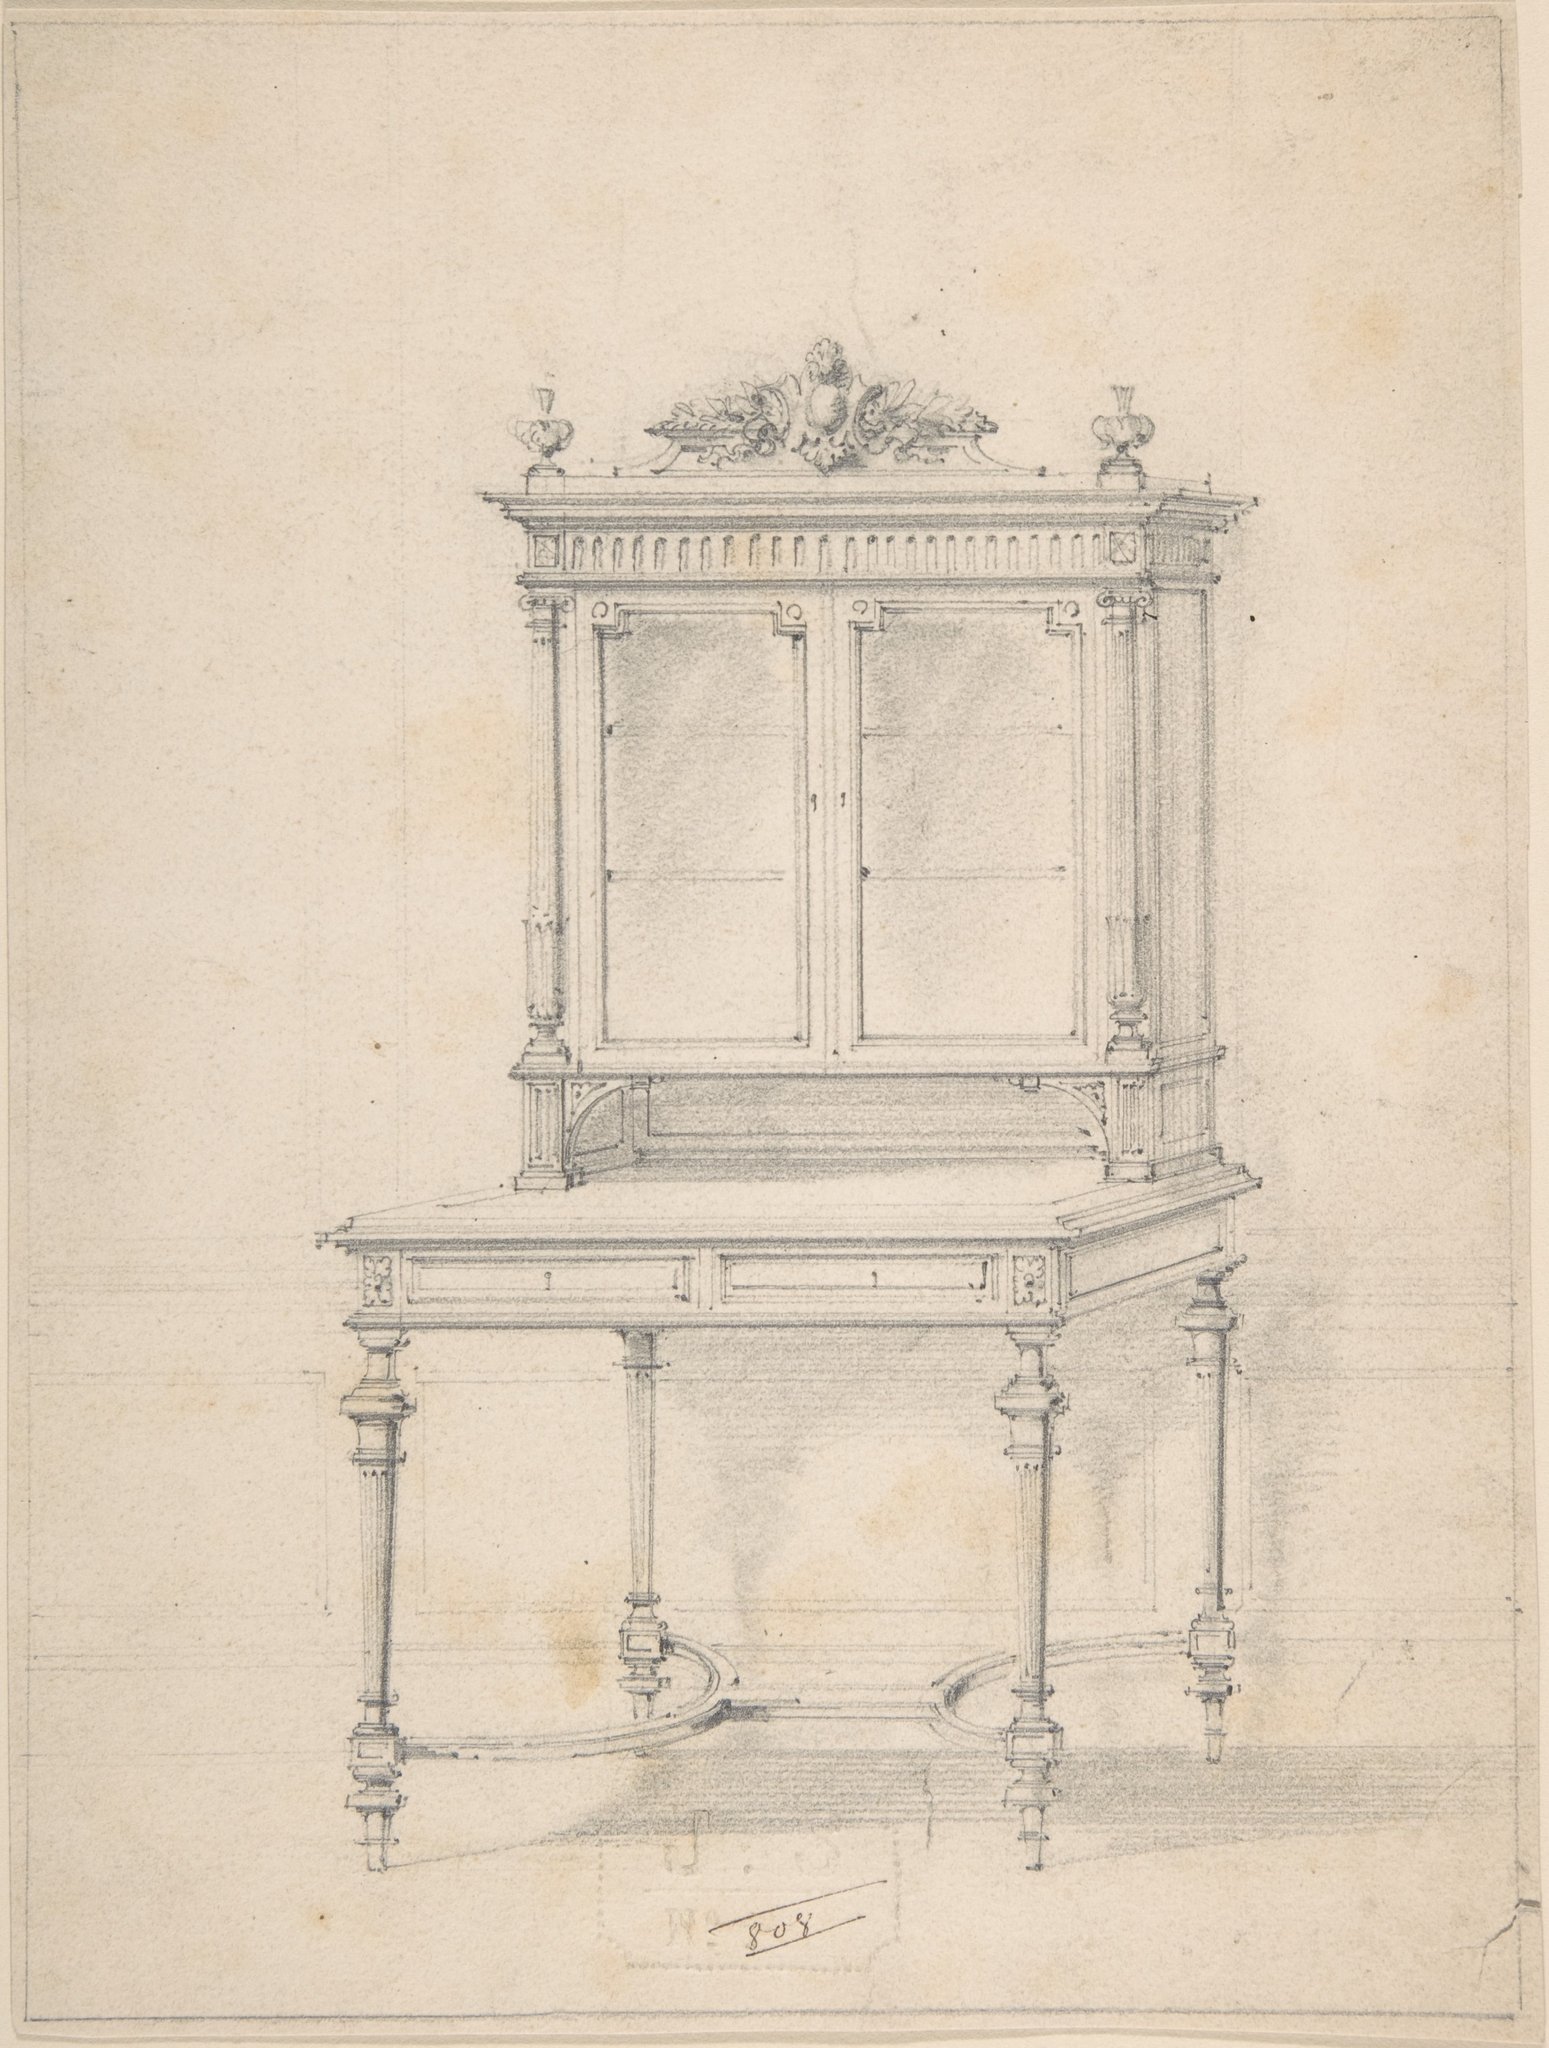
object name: drawing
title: Design for a Desk with Cabinet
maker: anonymous, french, 19th century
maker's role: artist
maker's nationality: french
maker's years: 1800-1900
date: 1801-1900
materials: graphite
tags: desks,cabinets